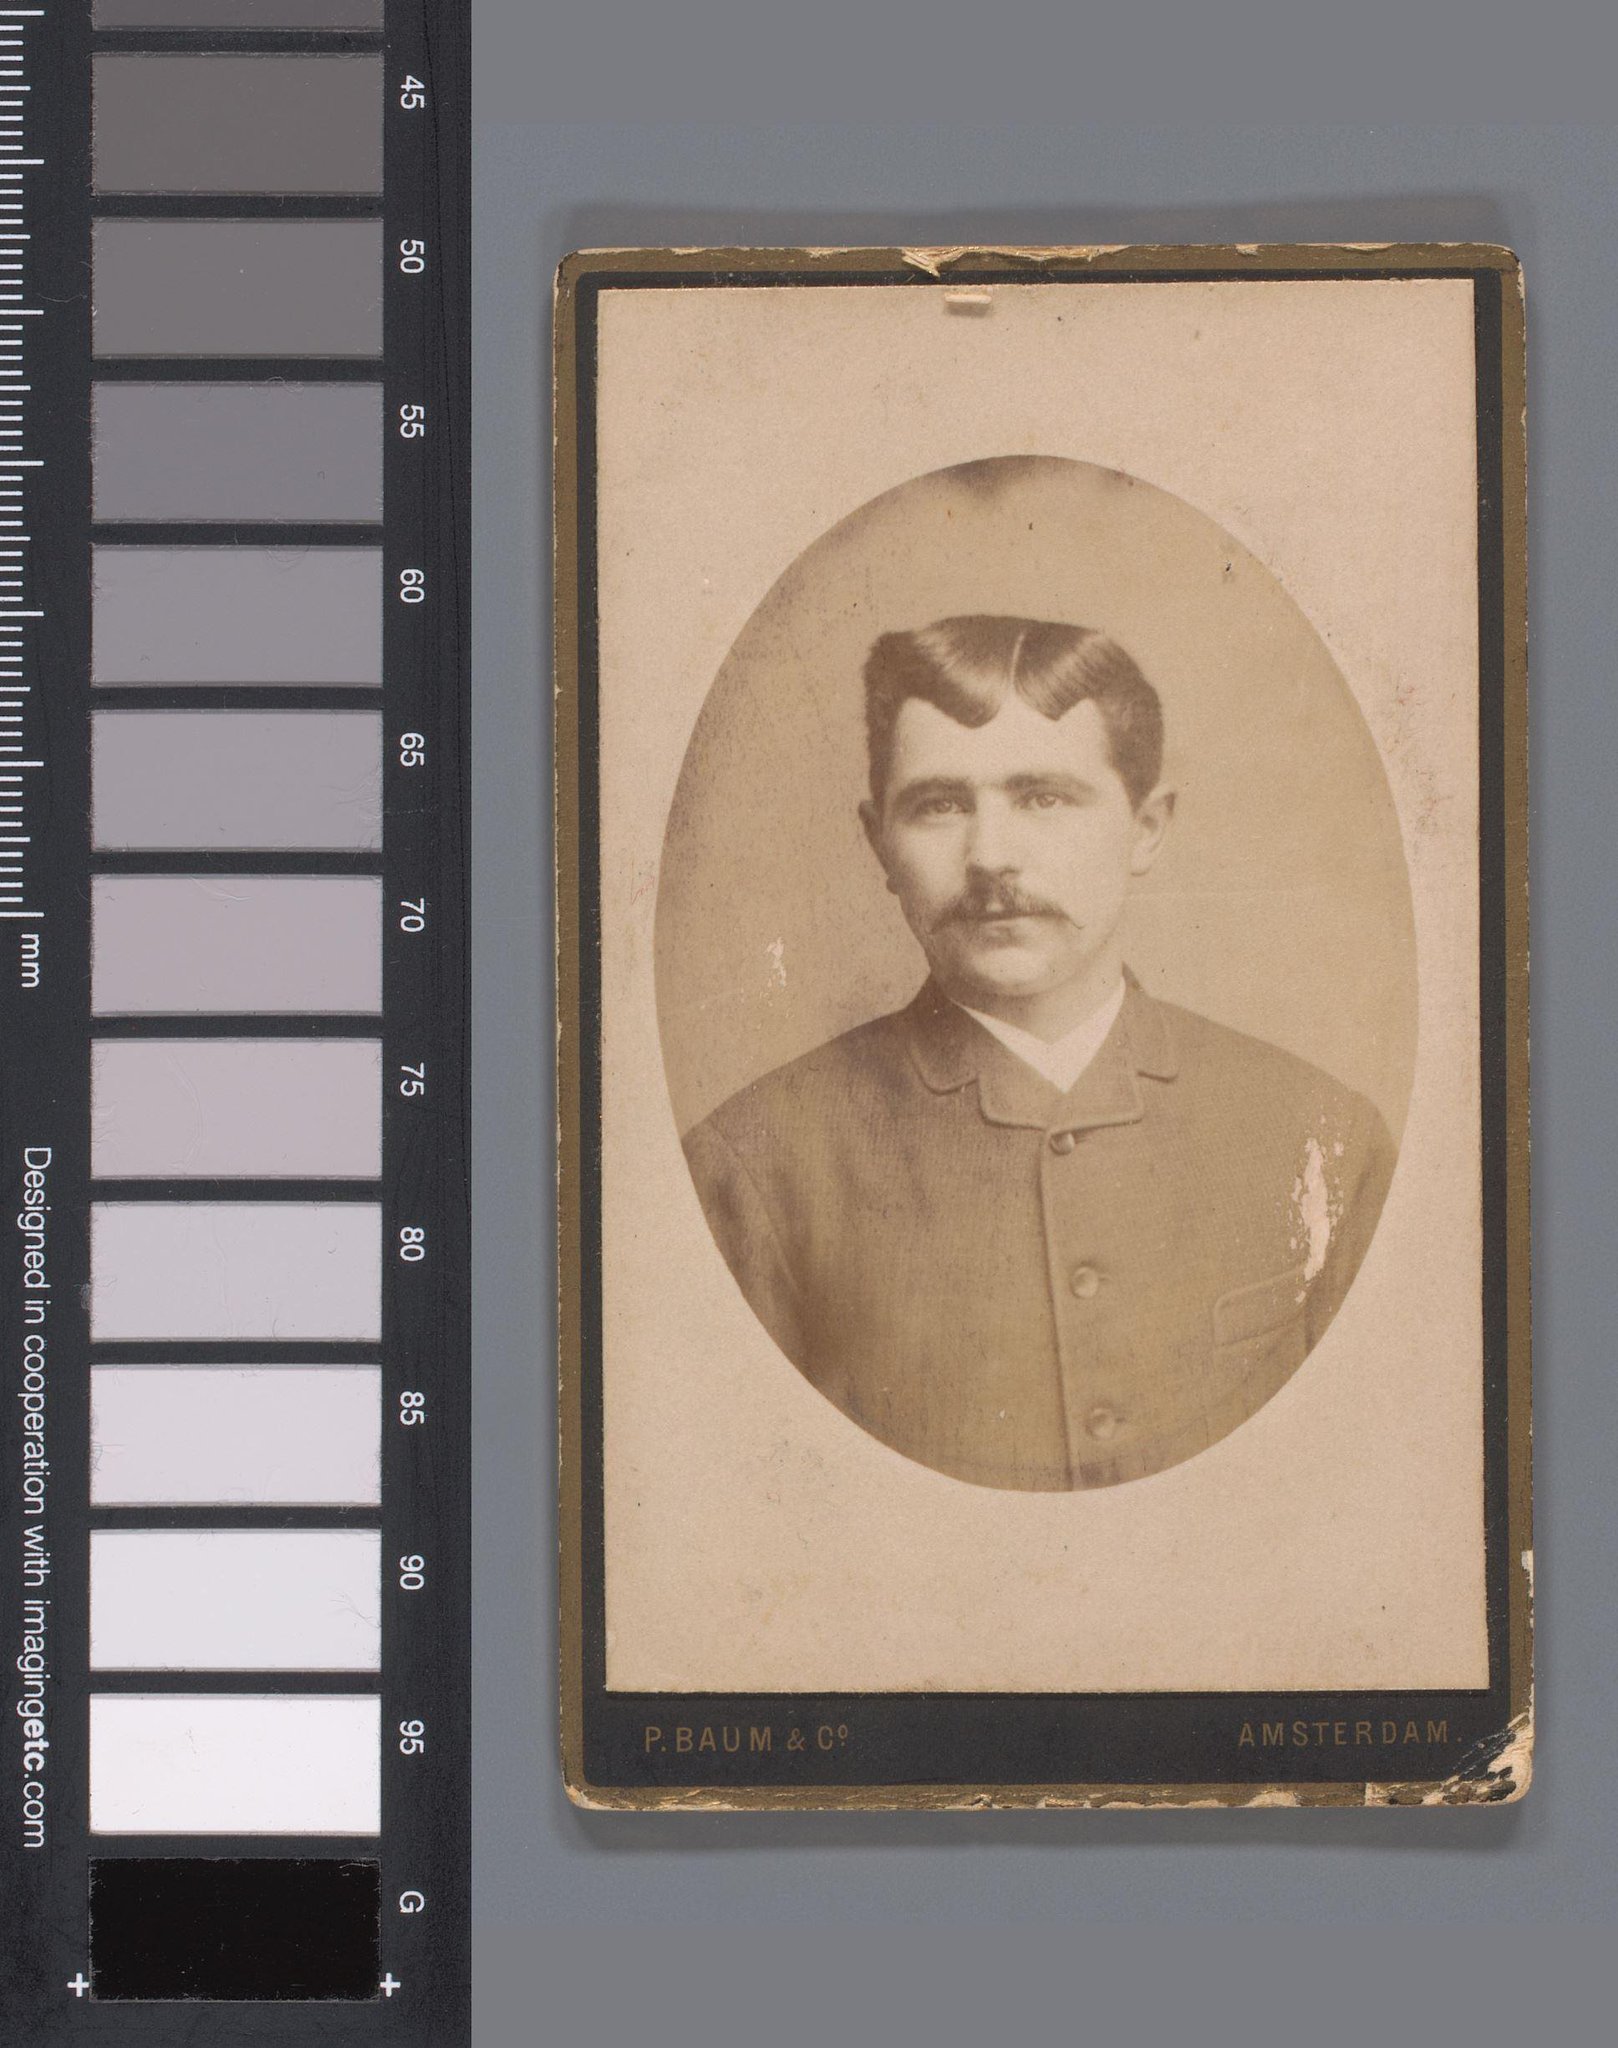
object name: semi enamel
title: Portret van een onbekende man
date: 1854-1885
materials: cardboard, celluloid, paper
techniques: albumen print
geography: amsterdam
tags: adult man, anonymous historical person portrayed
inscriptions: address: ‘Amsterdam/ NIEUWE HEERENGRACHT, 119a/ Recht/ over het Park.’, inscription: ‘SPECIALITEIT:/ Reproductien en Vergrootingen./ De platen blyven voor nabestellingen bewaard.’